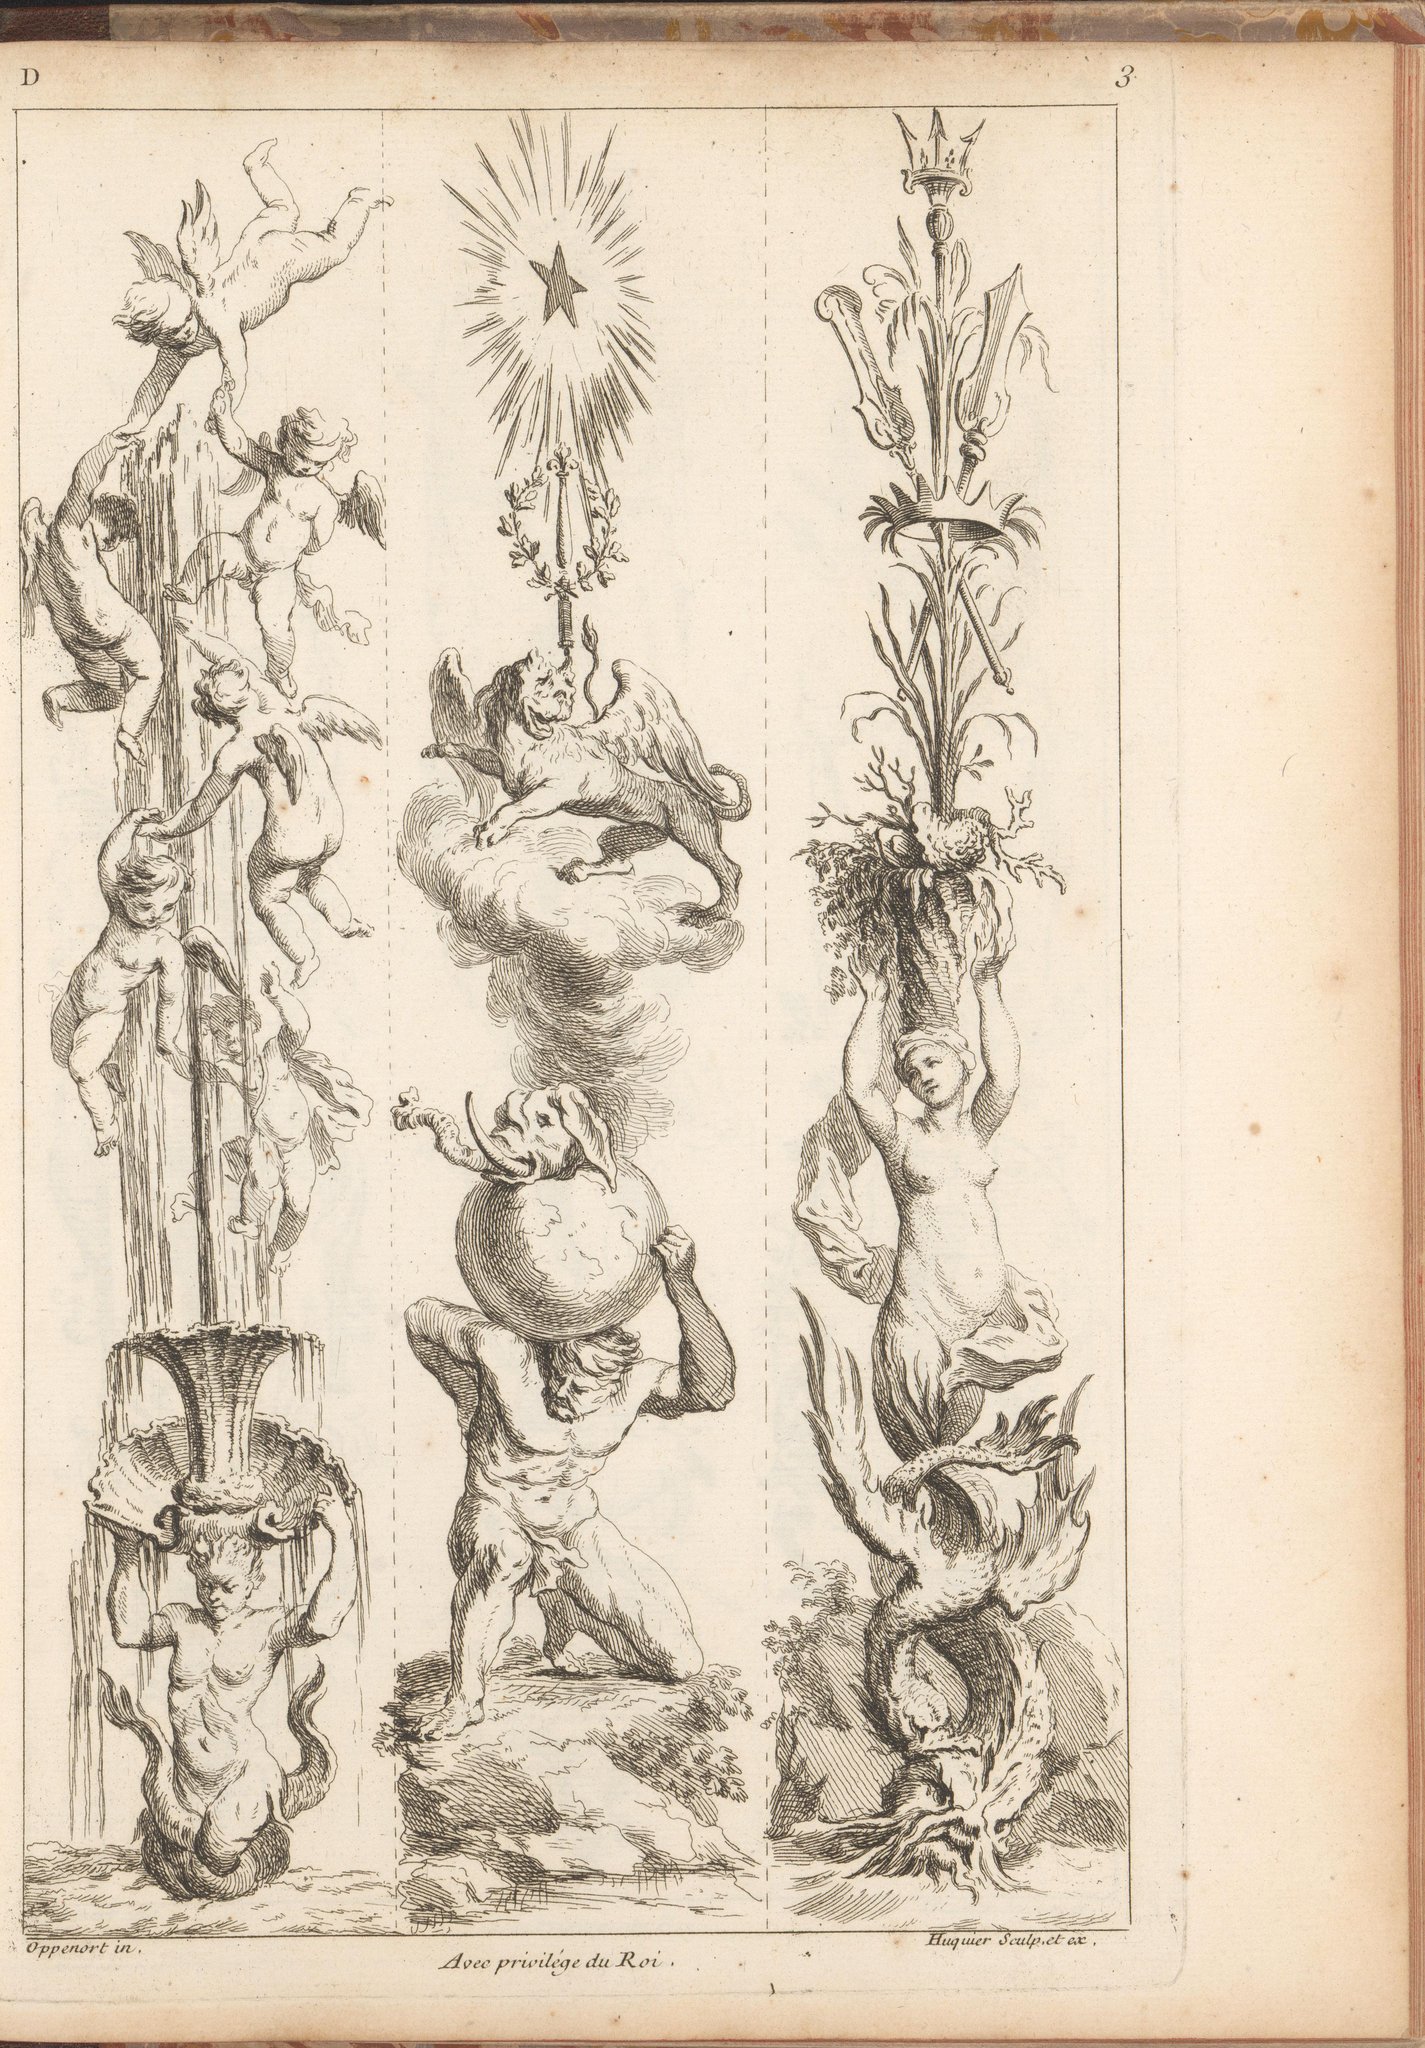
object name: ornament print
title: Drie ontwerpen voor verticale ornamenten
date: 1725-1750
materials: paper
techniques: etching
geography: paris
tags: griffin (lion/eagle); 'griffo' (ripa), ornaments ~ art, (story of) atlas, dragon, cupids: 'amores', 'amoretti', 'putti'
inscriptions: collector's mark: Lugt 2228a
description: Links een fontein met putti, gedragen door een meermin. In het midden Atlas met wereldbol, olifantenkop en een griffioen. Rechts een draak, een vrouw en wapens. Deze prent maakt deel uit van een album.